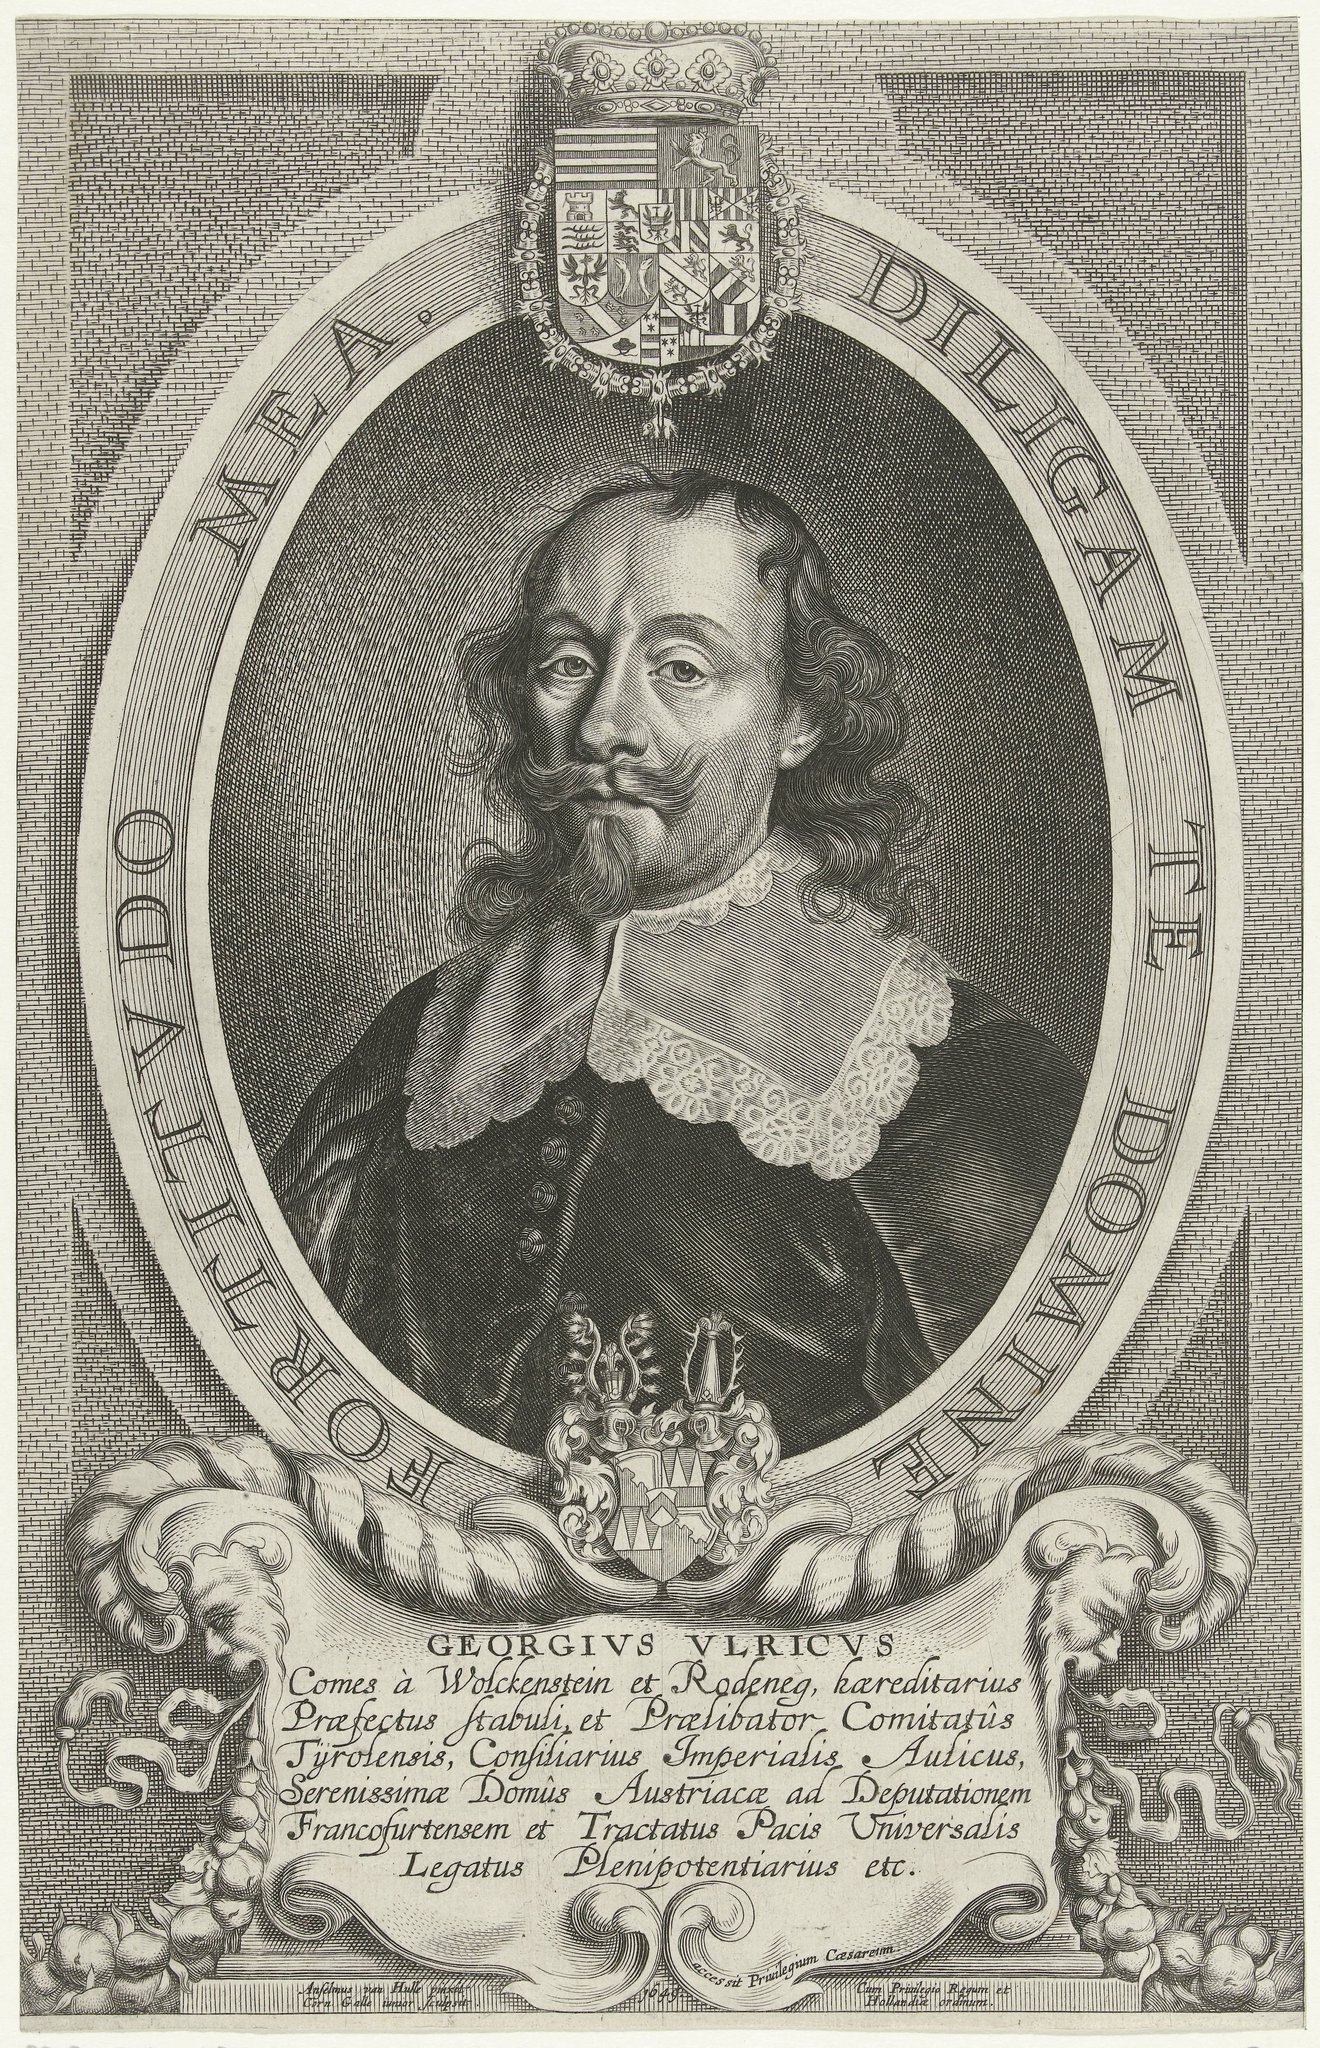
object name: print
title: Portret van Georg Ulrich von Wolkenstein und Rodenegg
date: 1649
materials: paper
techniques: engraving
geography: antwerp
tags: regensburg, afgezant, raadslid, kamerheer, georg ulrich graaf van wolkenstein-rodenegg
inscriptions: collector's mark: Lugt 2228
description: Portret van Georg Ulrich von Wolkenstein und Rodenegg, afgezant voor Oostenrijk tijdens de onderhandelingen voor de Vrede van Münster. Portret in ovaal met motto: Diligam te domine fortitudo mea. Onder het familiewapen van Wolkenstein-Rodenegg.